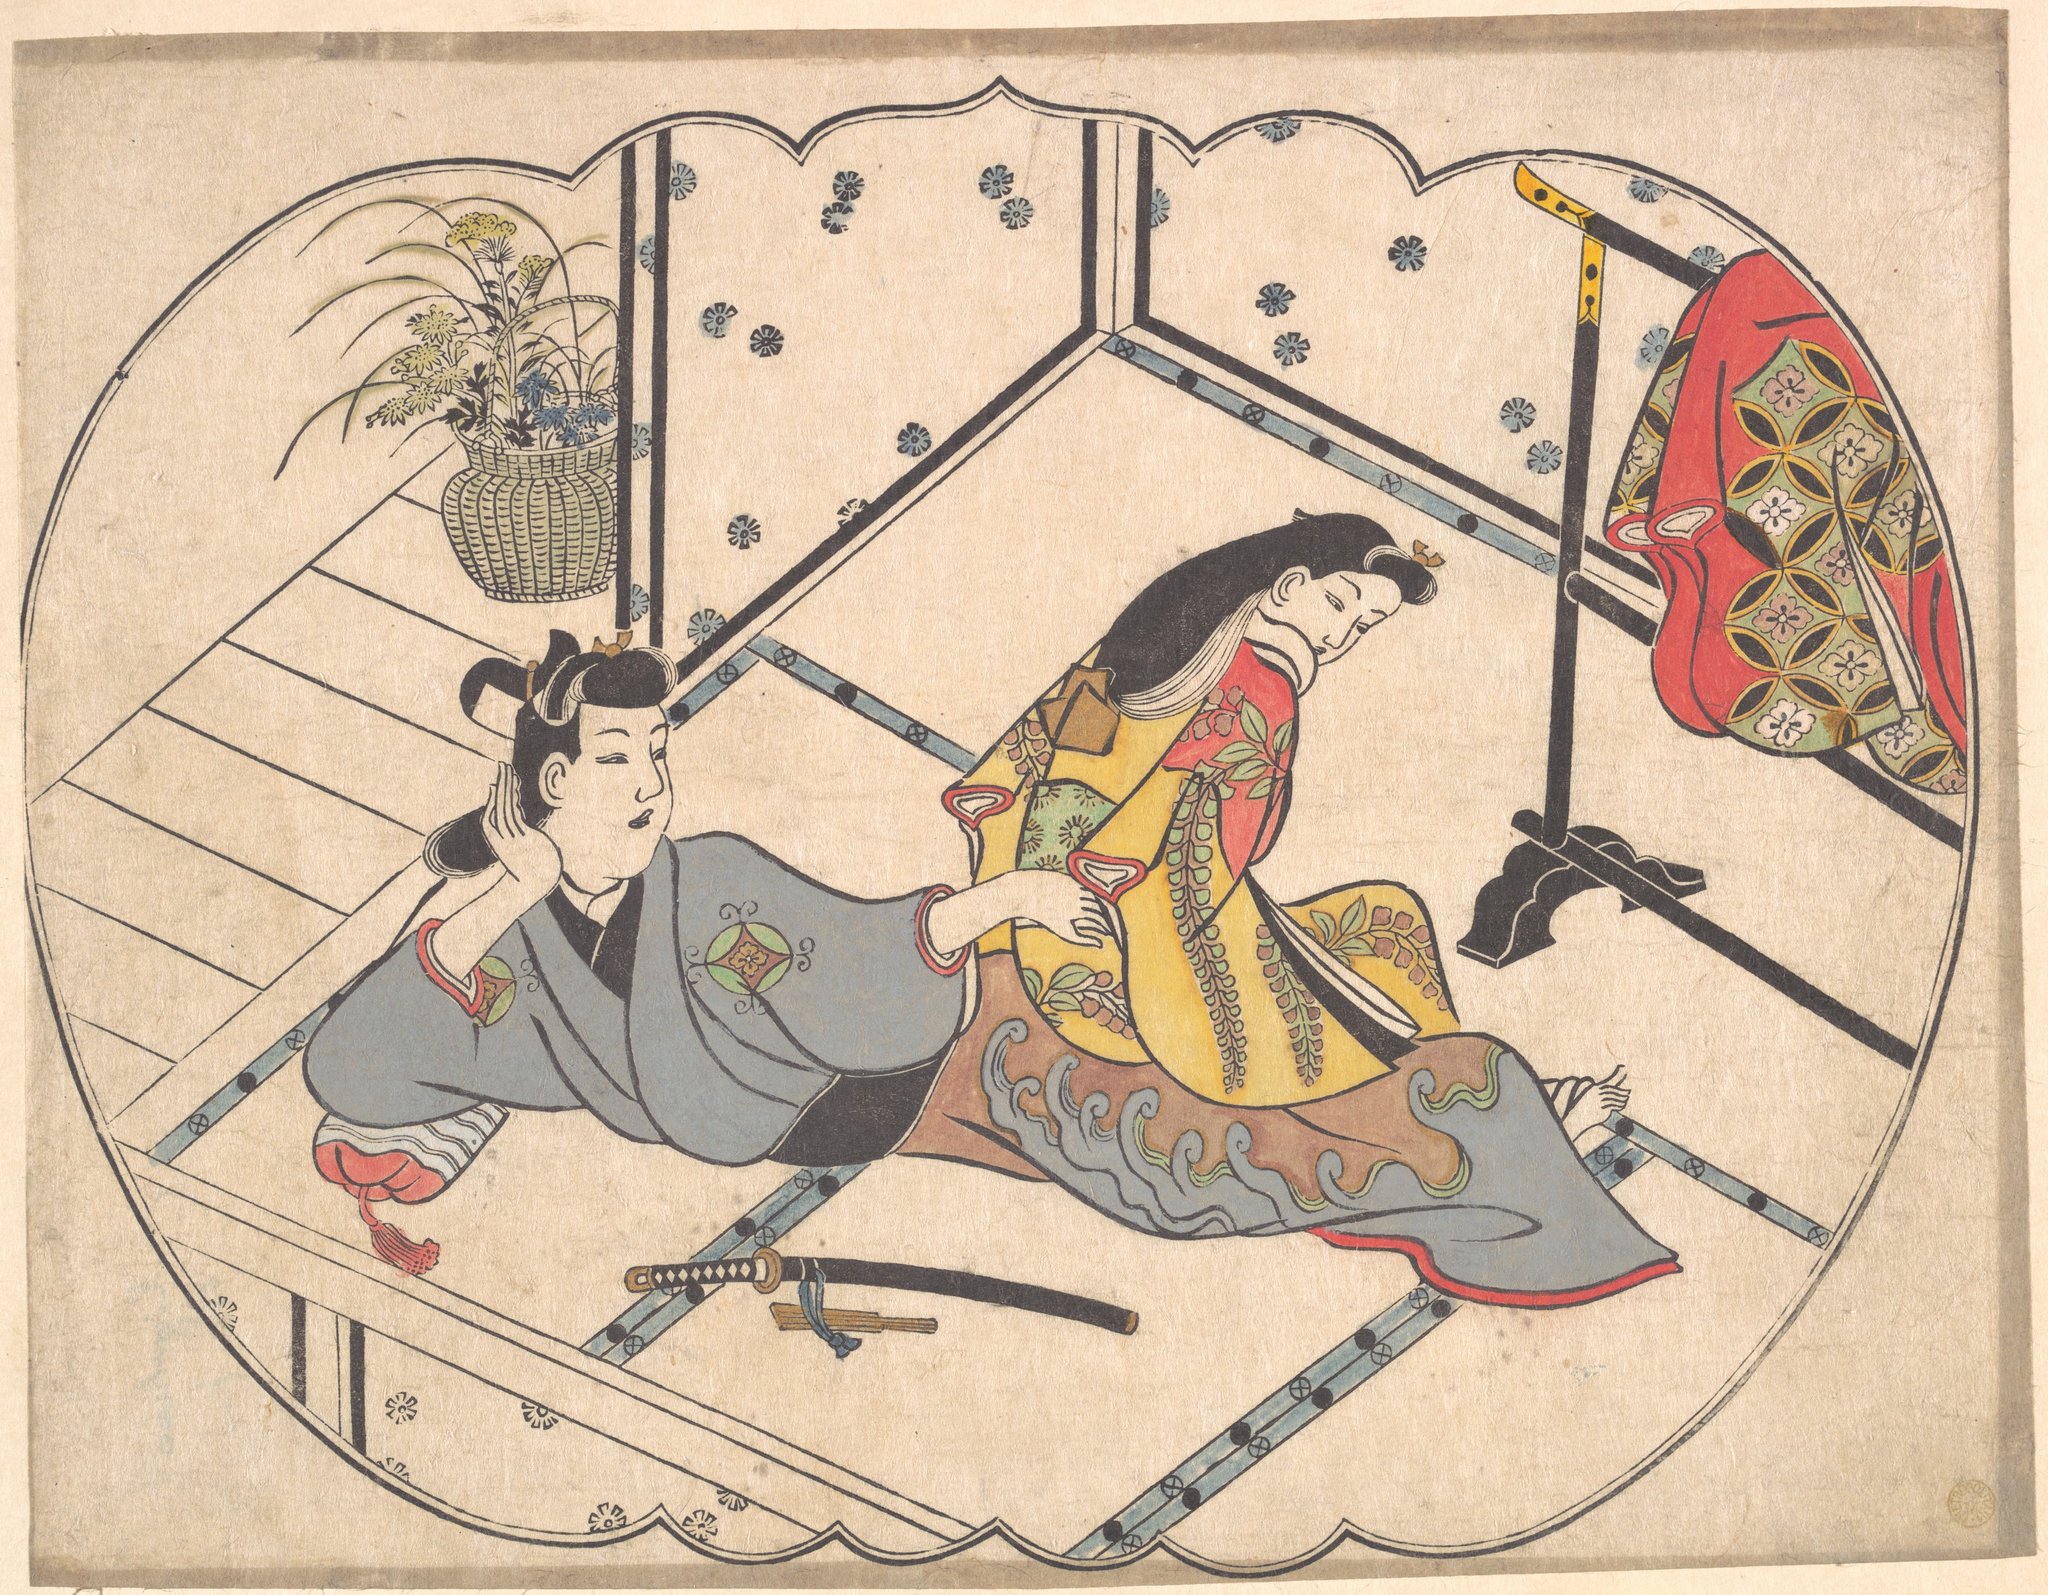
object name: print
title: Scene in a Joroya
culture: japanese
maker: furuyama moroshige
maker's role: artist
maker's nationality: japanese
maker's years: 1650-1699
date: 1690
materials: ink, paper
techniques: woodblock print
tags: swords,women